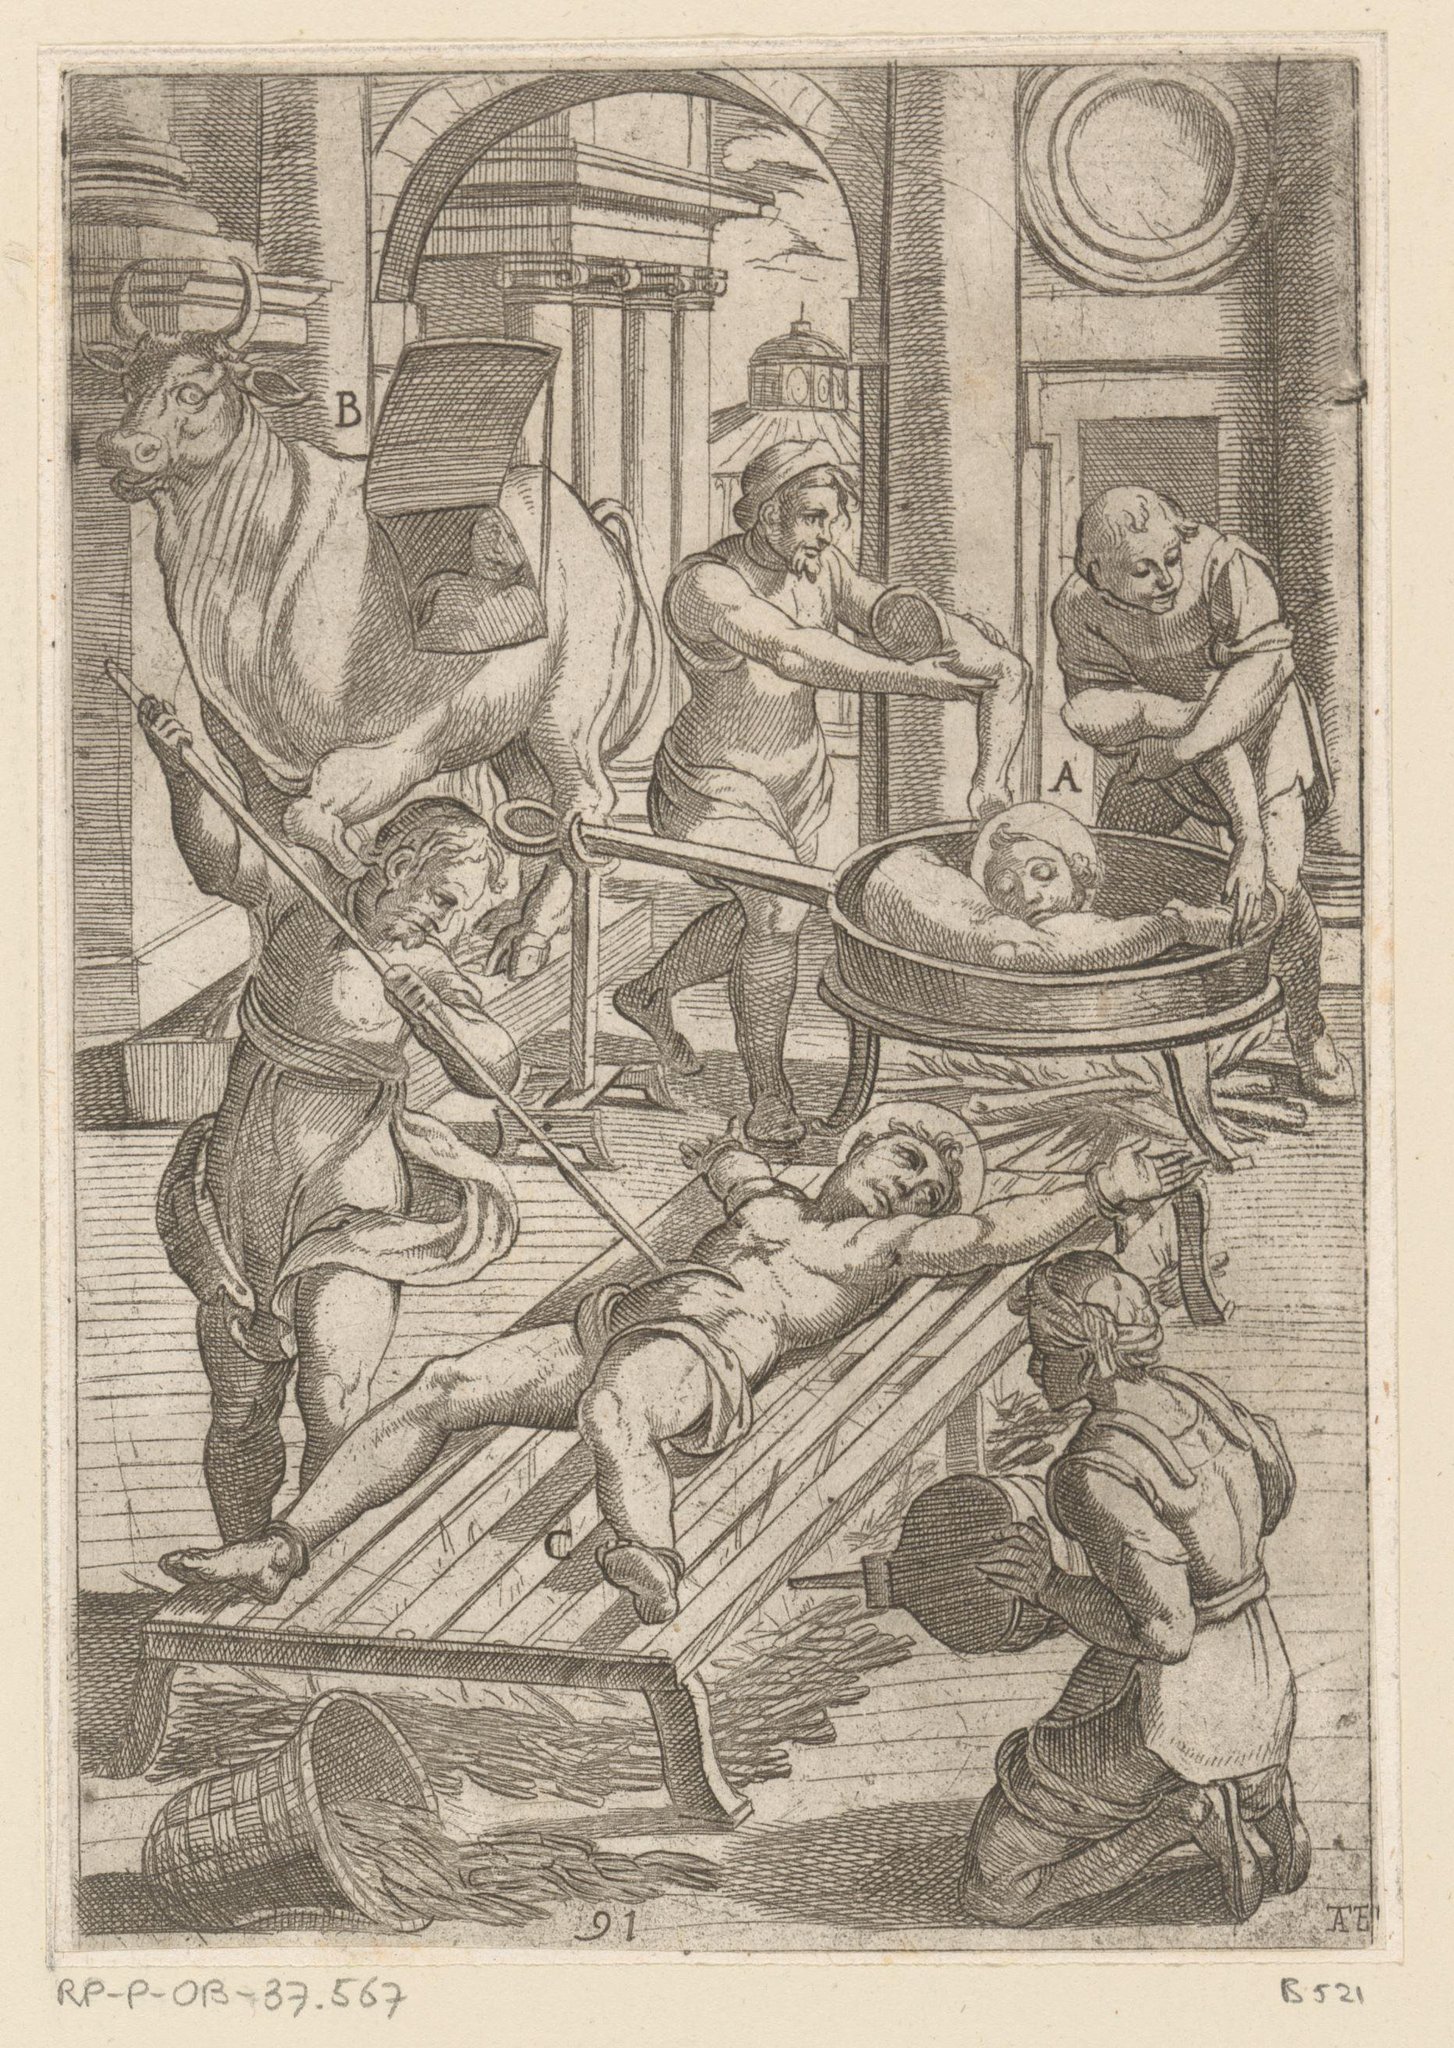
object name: print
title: Varia tormentorum et supplicioru crudelium (...)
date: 1565-1630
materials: paper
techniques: etching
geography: italy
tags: violent death ~ maltreatment, torture, torture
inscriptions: collector's mark: Lugt 240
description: Deze prent maakt deel uit van een reeks van 47 prenten (+ titelprent) met voorstellingen van martelmethoden. Deze prenten zijn in een andere editie gebruikt als illustraties voor Antonio Gallonio's 'Trattato degli Instrumenti di Martirio e delle Varie Maniere di Martoriare Usate dai Gentili contro Christiani' (Rome, Ascanio en Girolamo Dongangeli, 1591).